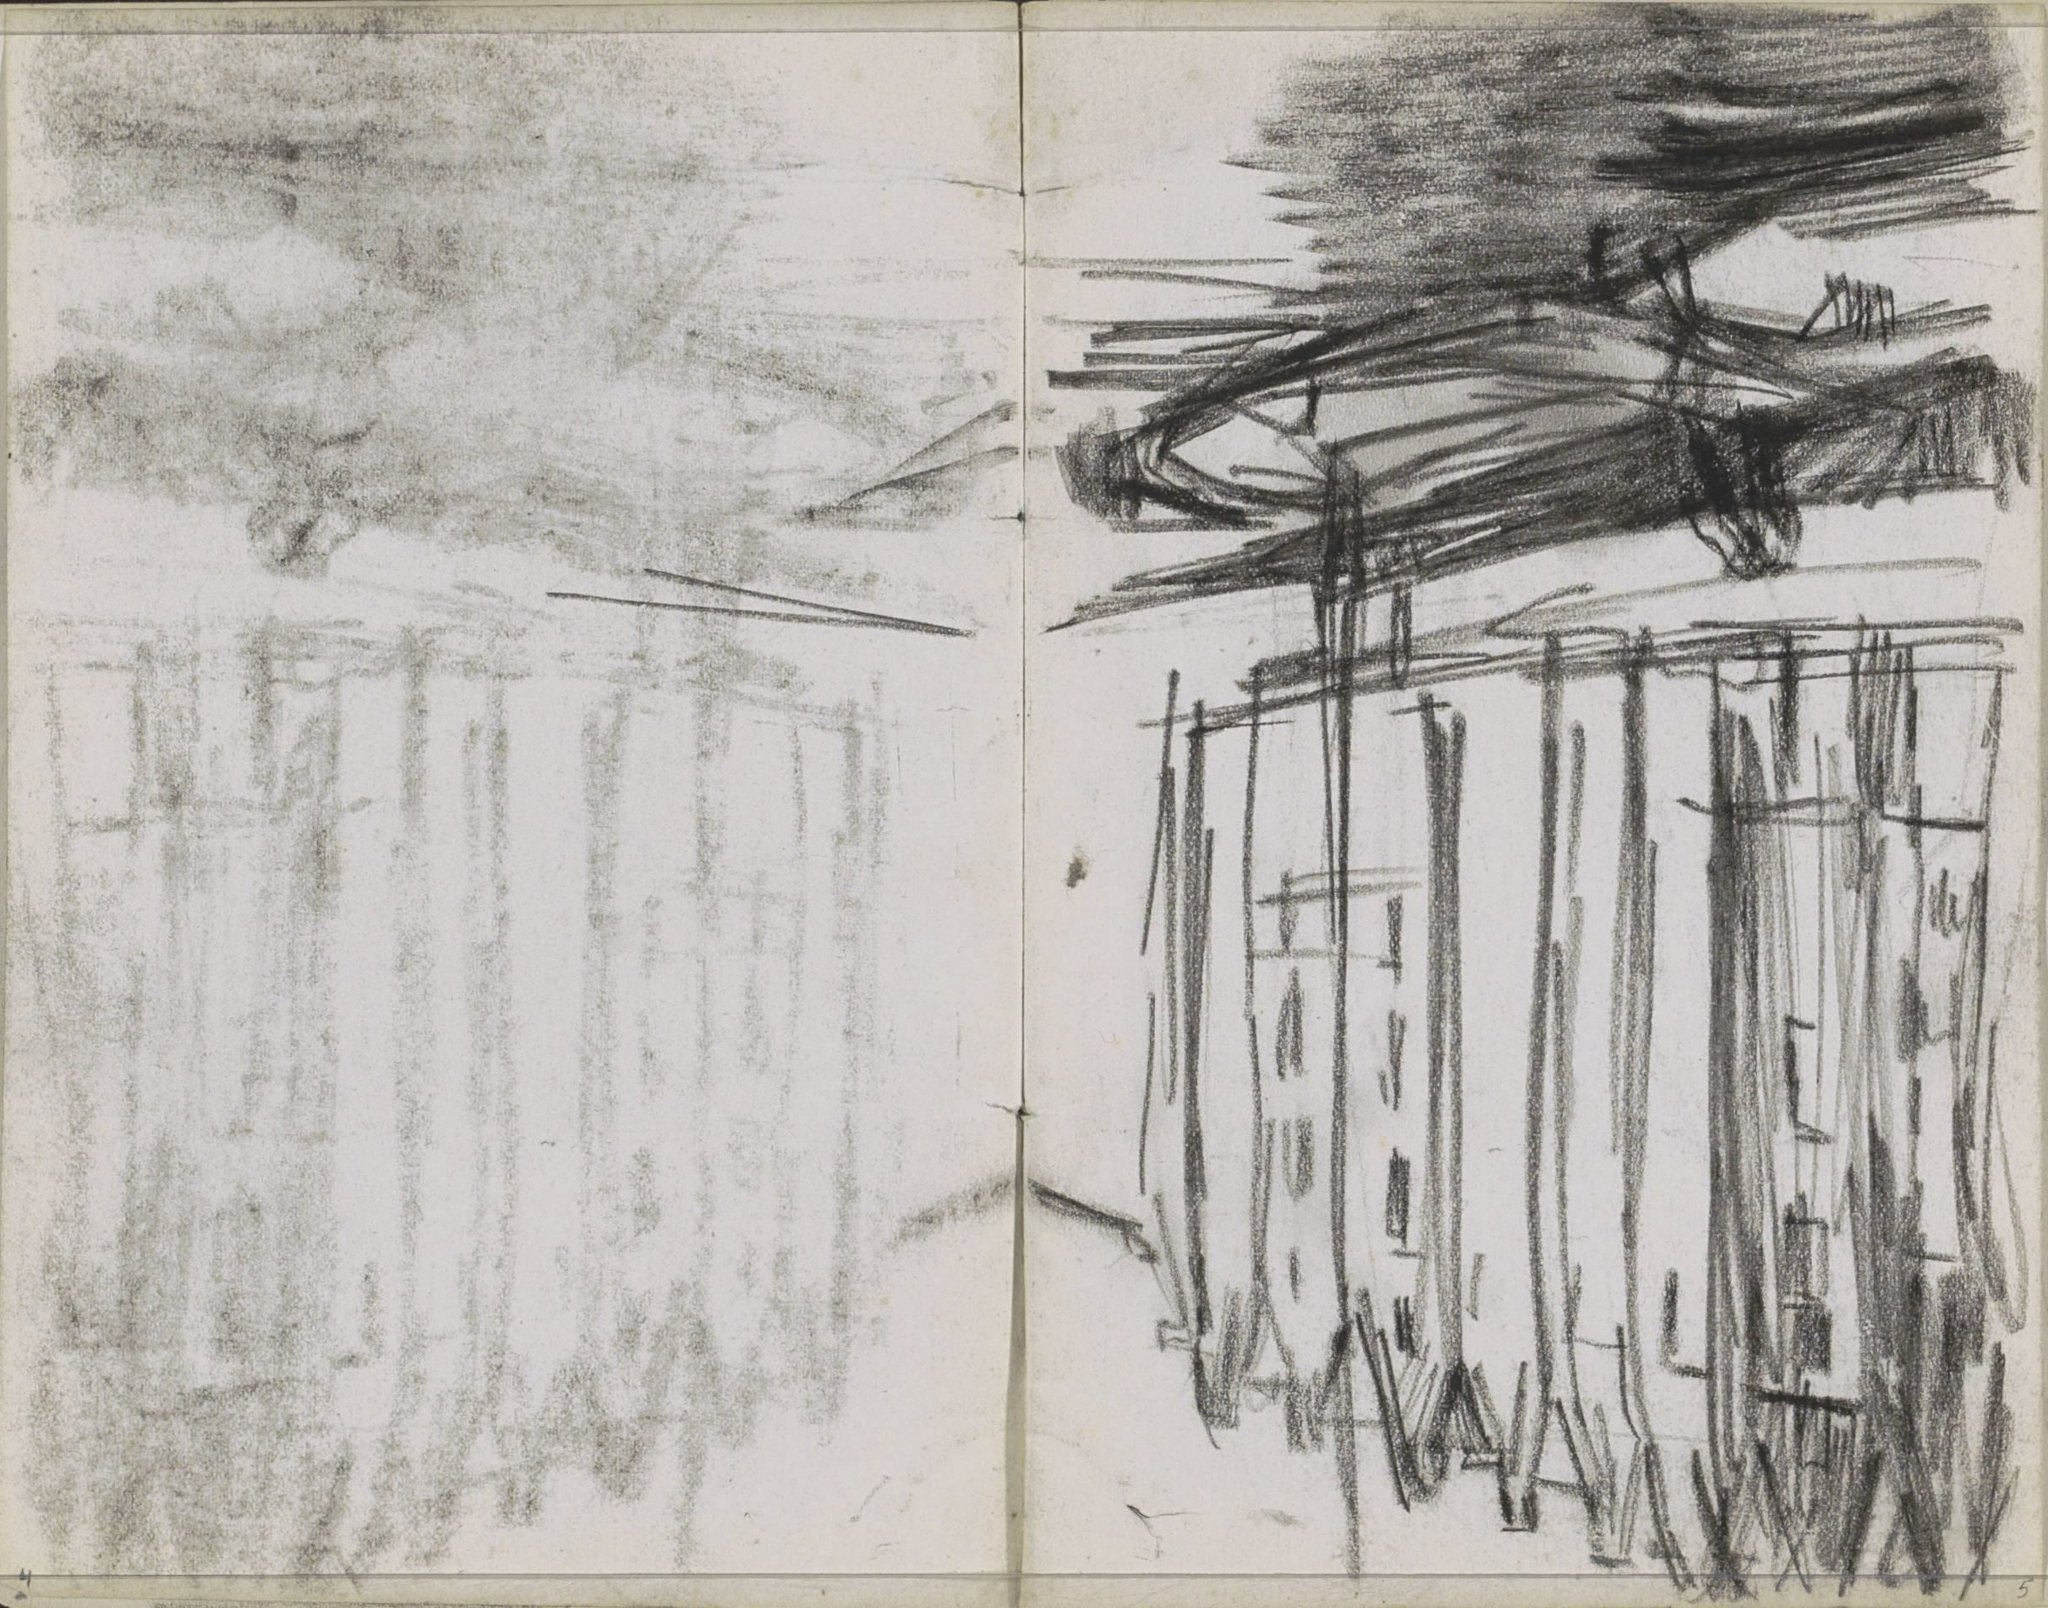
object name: sketchbook leaf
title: Boot in een gracht, mogelijk in Amsterdam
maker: isaac israels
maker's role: draughtsman, painter, print maker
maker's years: 1865-1934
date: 1875-1934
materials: chalk, paper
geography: amsterdam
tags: ships (in general), canals, waters (in city), amsterdam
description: Pagina 4 en pagina 5 uit schetsboek XXIX met 44 pagina's.